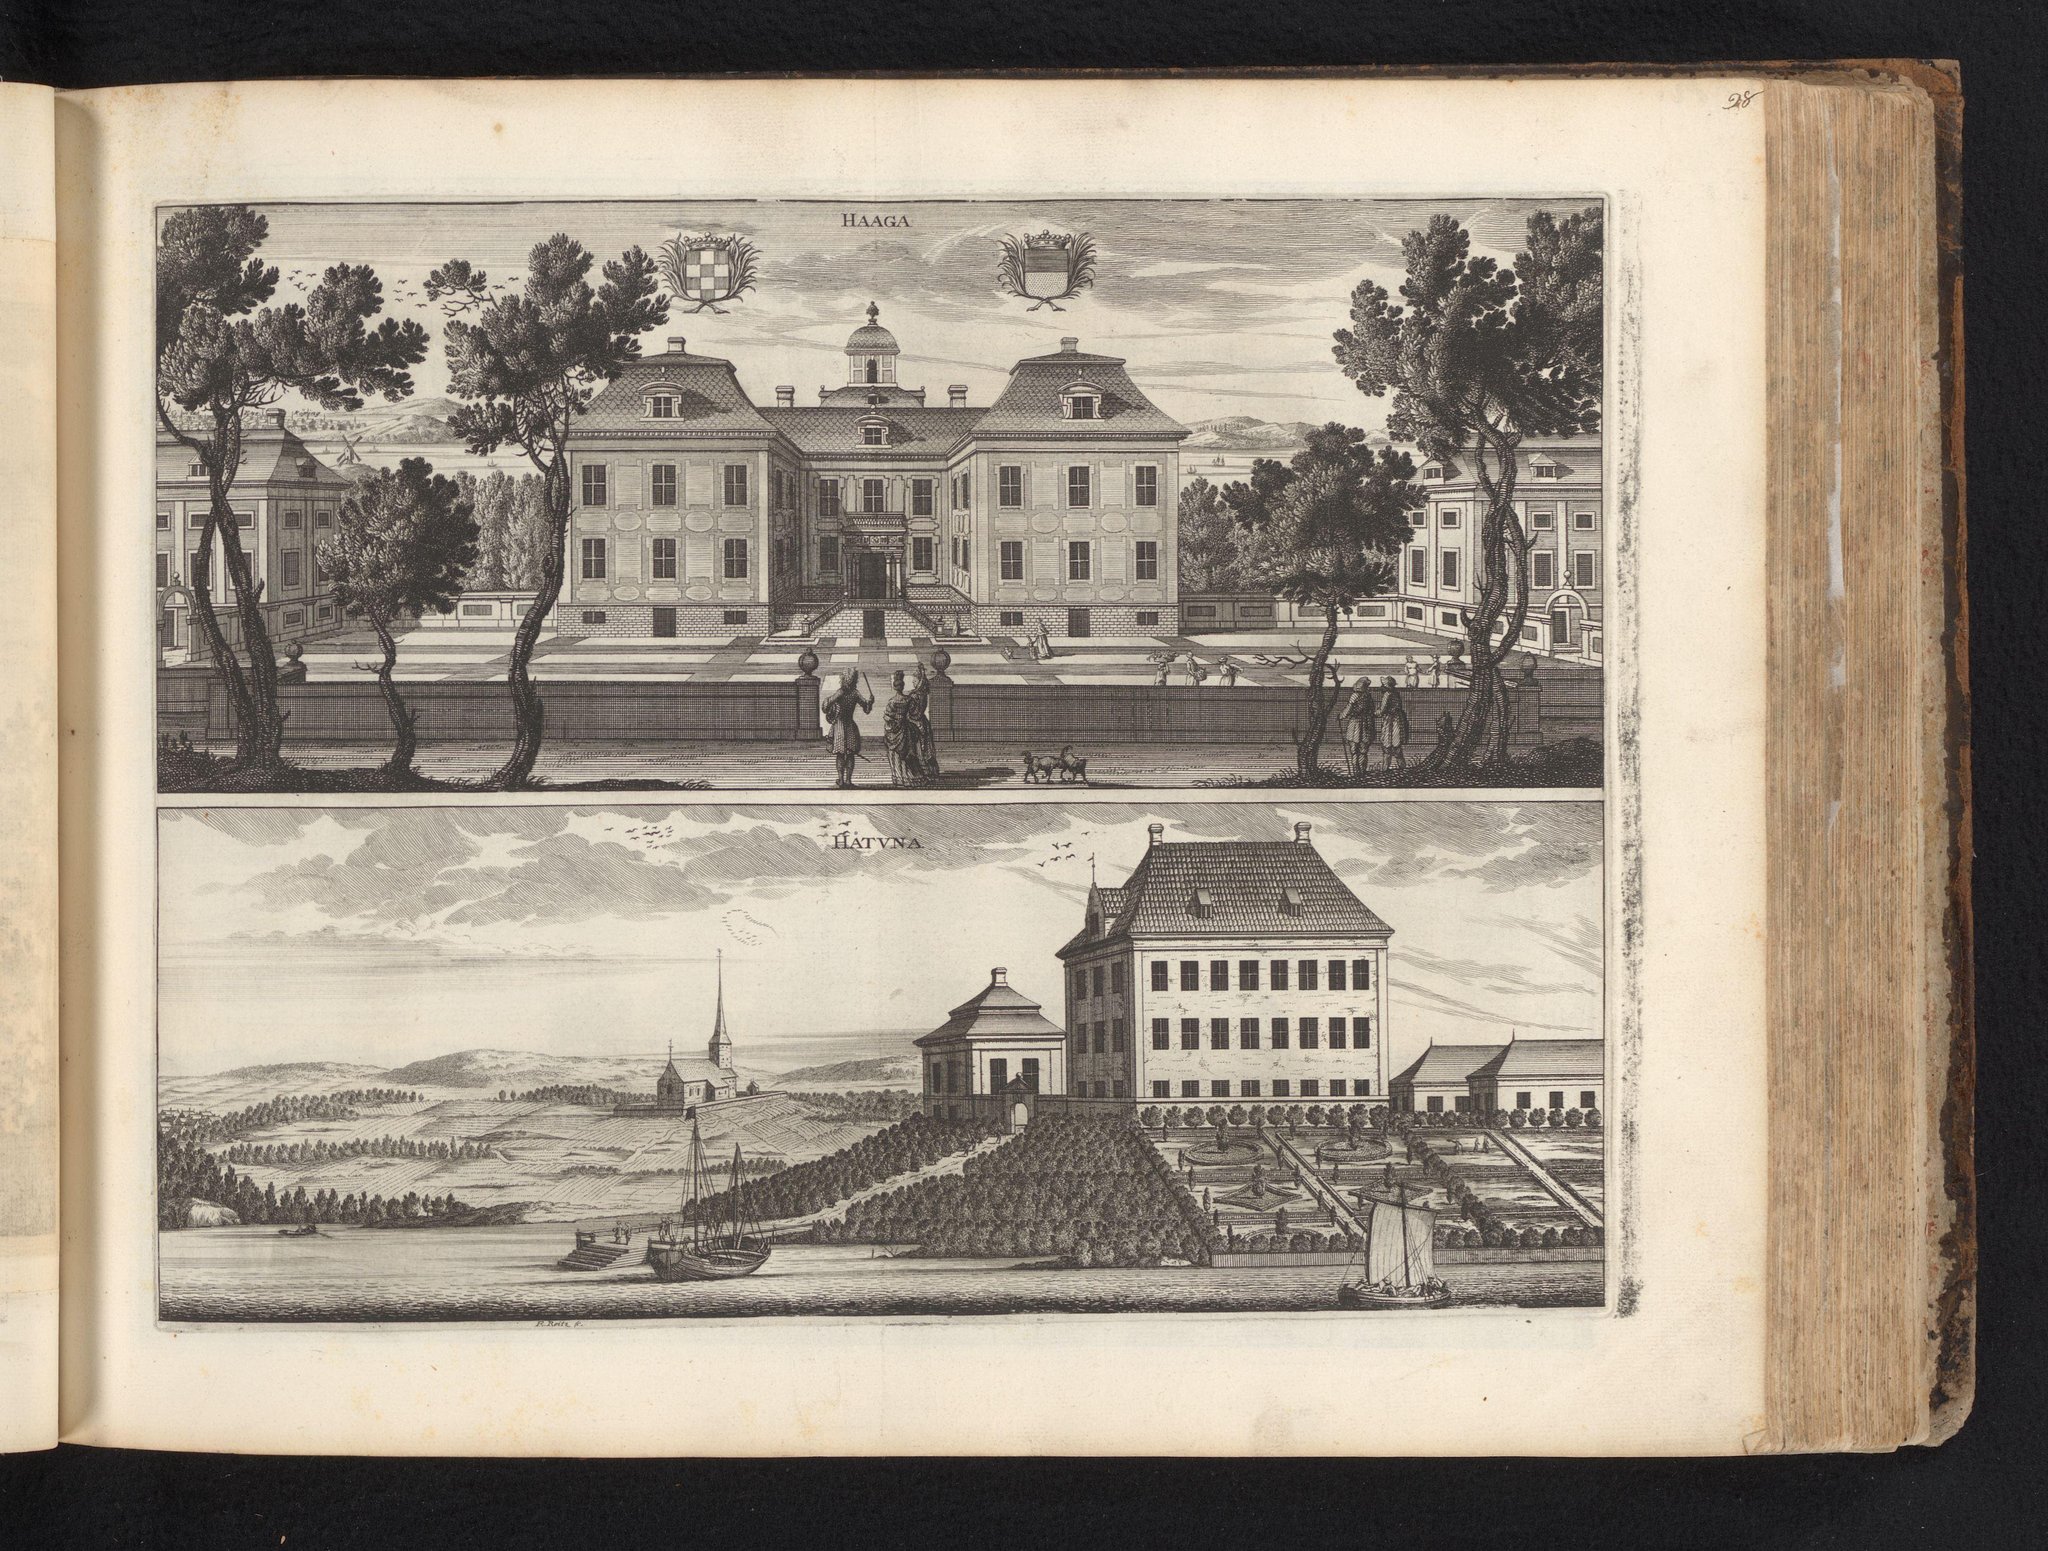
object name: print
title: Suecia Antiqua et Hodierna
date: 1694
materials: paper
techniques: etching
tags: housing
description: Kungliga Biblioteket, 'Suecia': http://www.kb.se/samlingarna/Kartor-bilder/Suecia-antiqua/ (geraadpleegd november 2016).